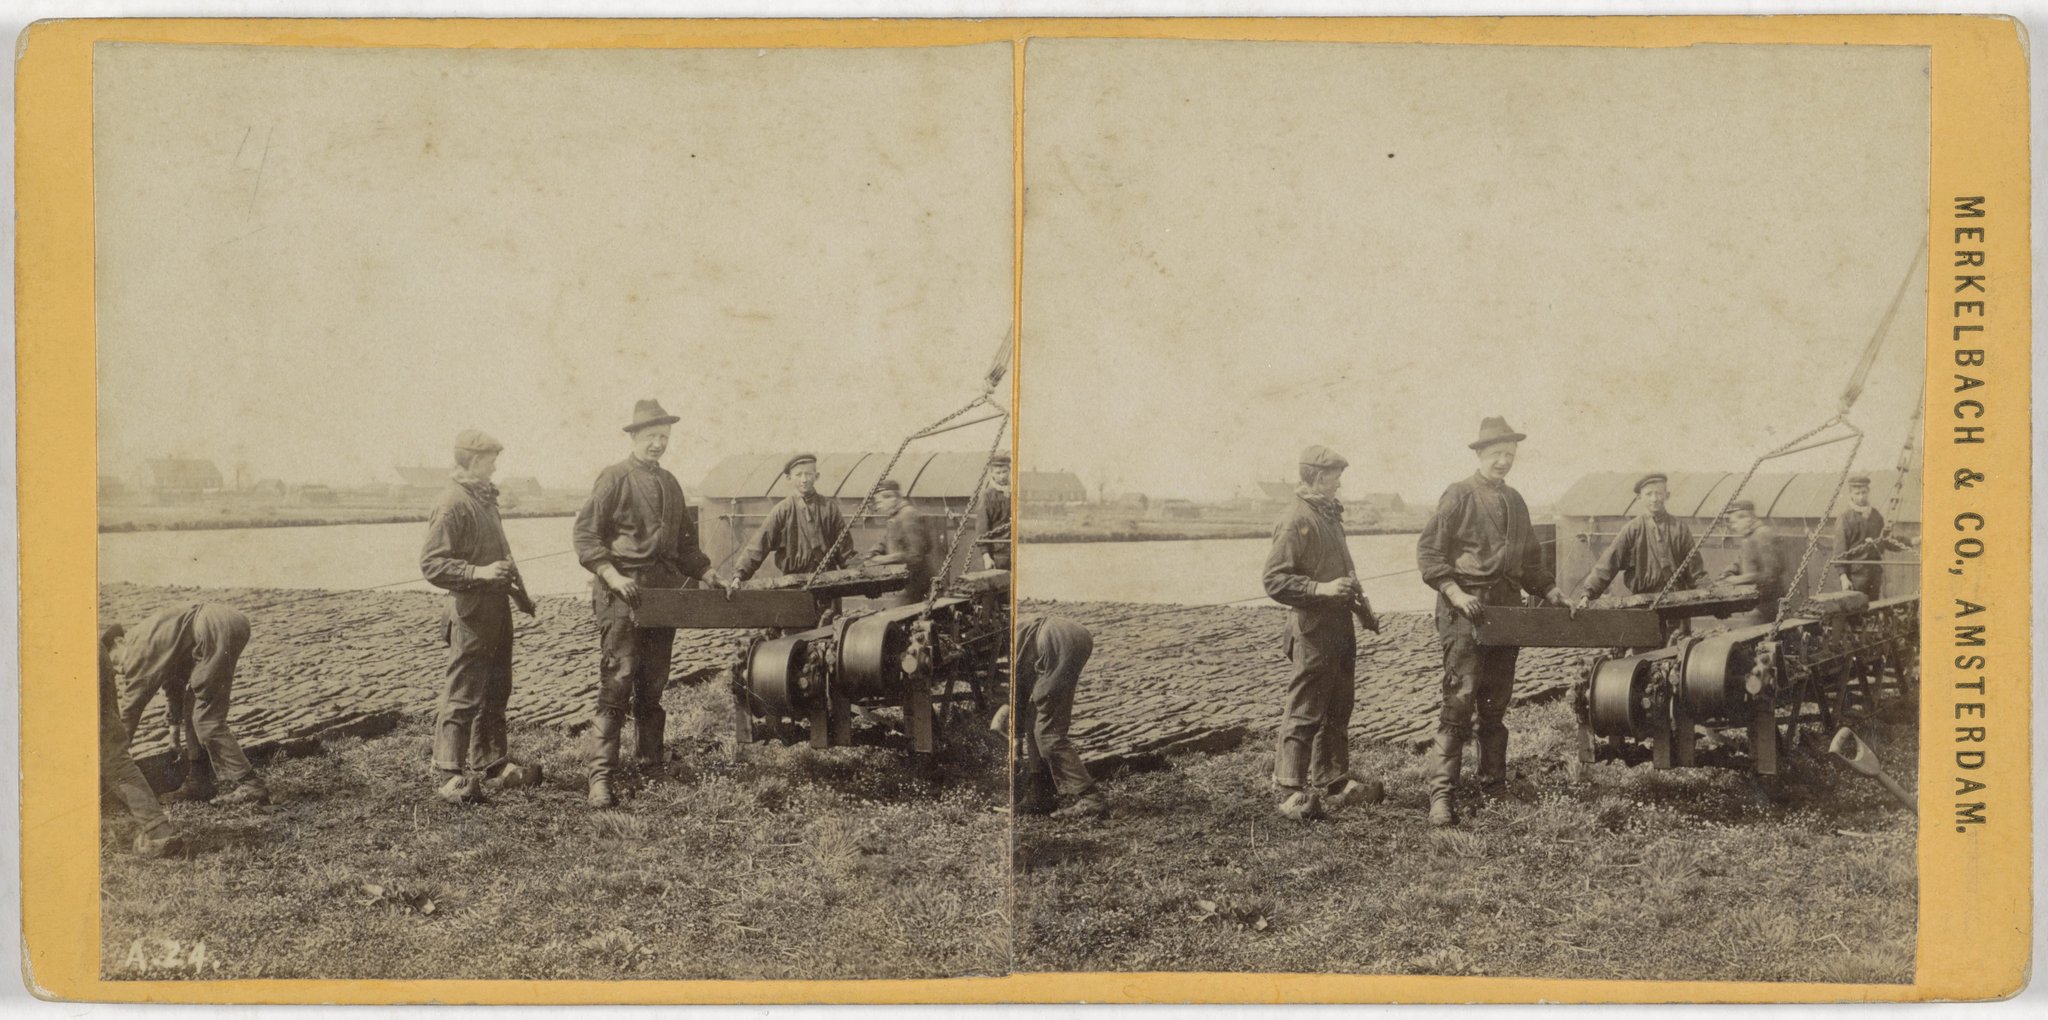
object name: stereograph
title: Geperste turf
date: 1900-1902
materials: cardboard, paper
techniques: albumen print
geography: netherlands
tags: peat-cutting, netherlands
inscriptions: number: ‘24.’, number: ‘A.24.’, inscription: ‘Zie pl. 23. De machine schuift de geperste en gesneden stukken veen op/ plankjes langs een riem zonder eind aan de turfdragers toe, die de plankjes/ omkeeren op den grond, waar de turven nu drogen moeten.’